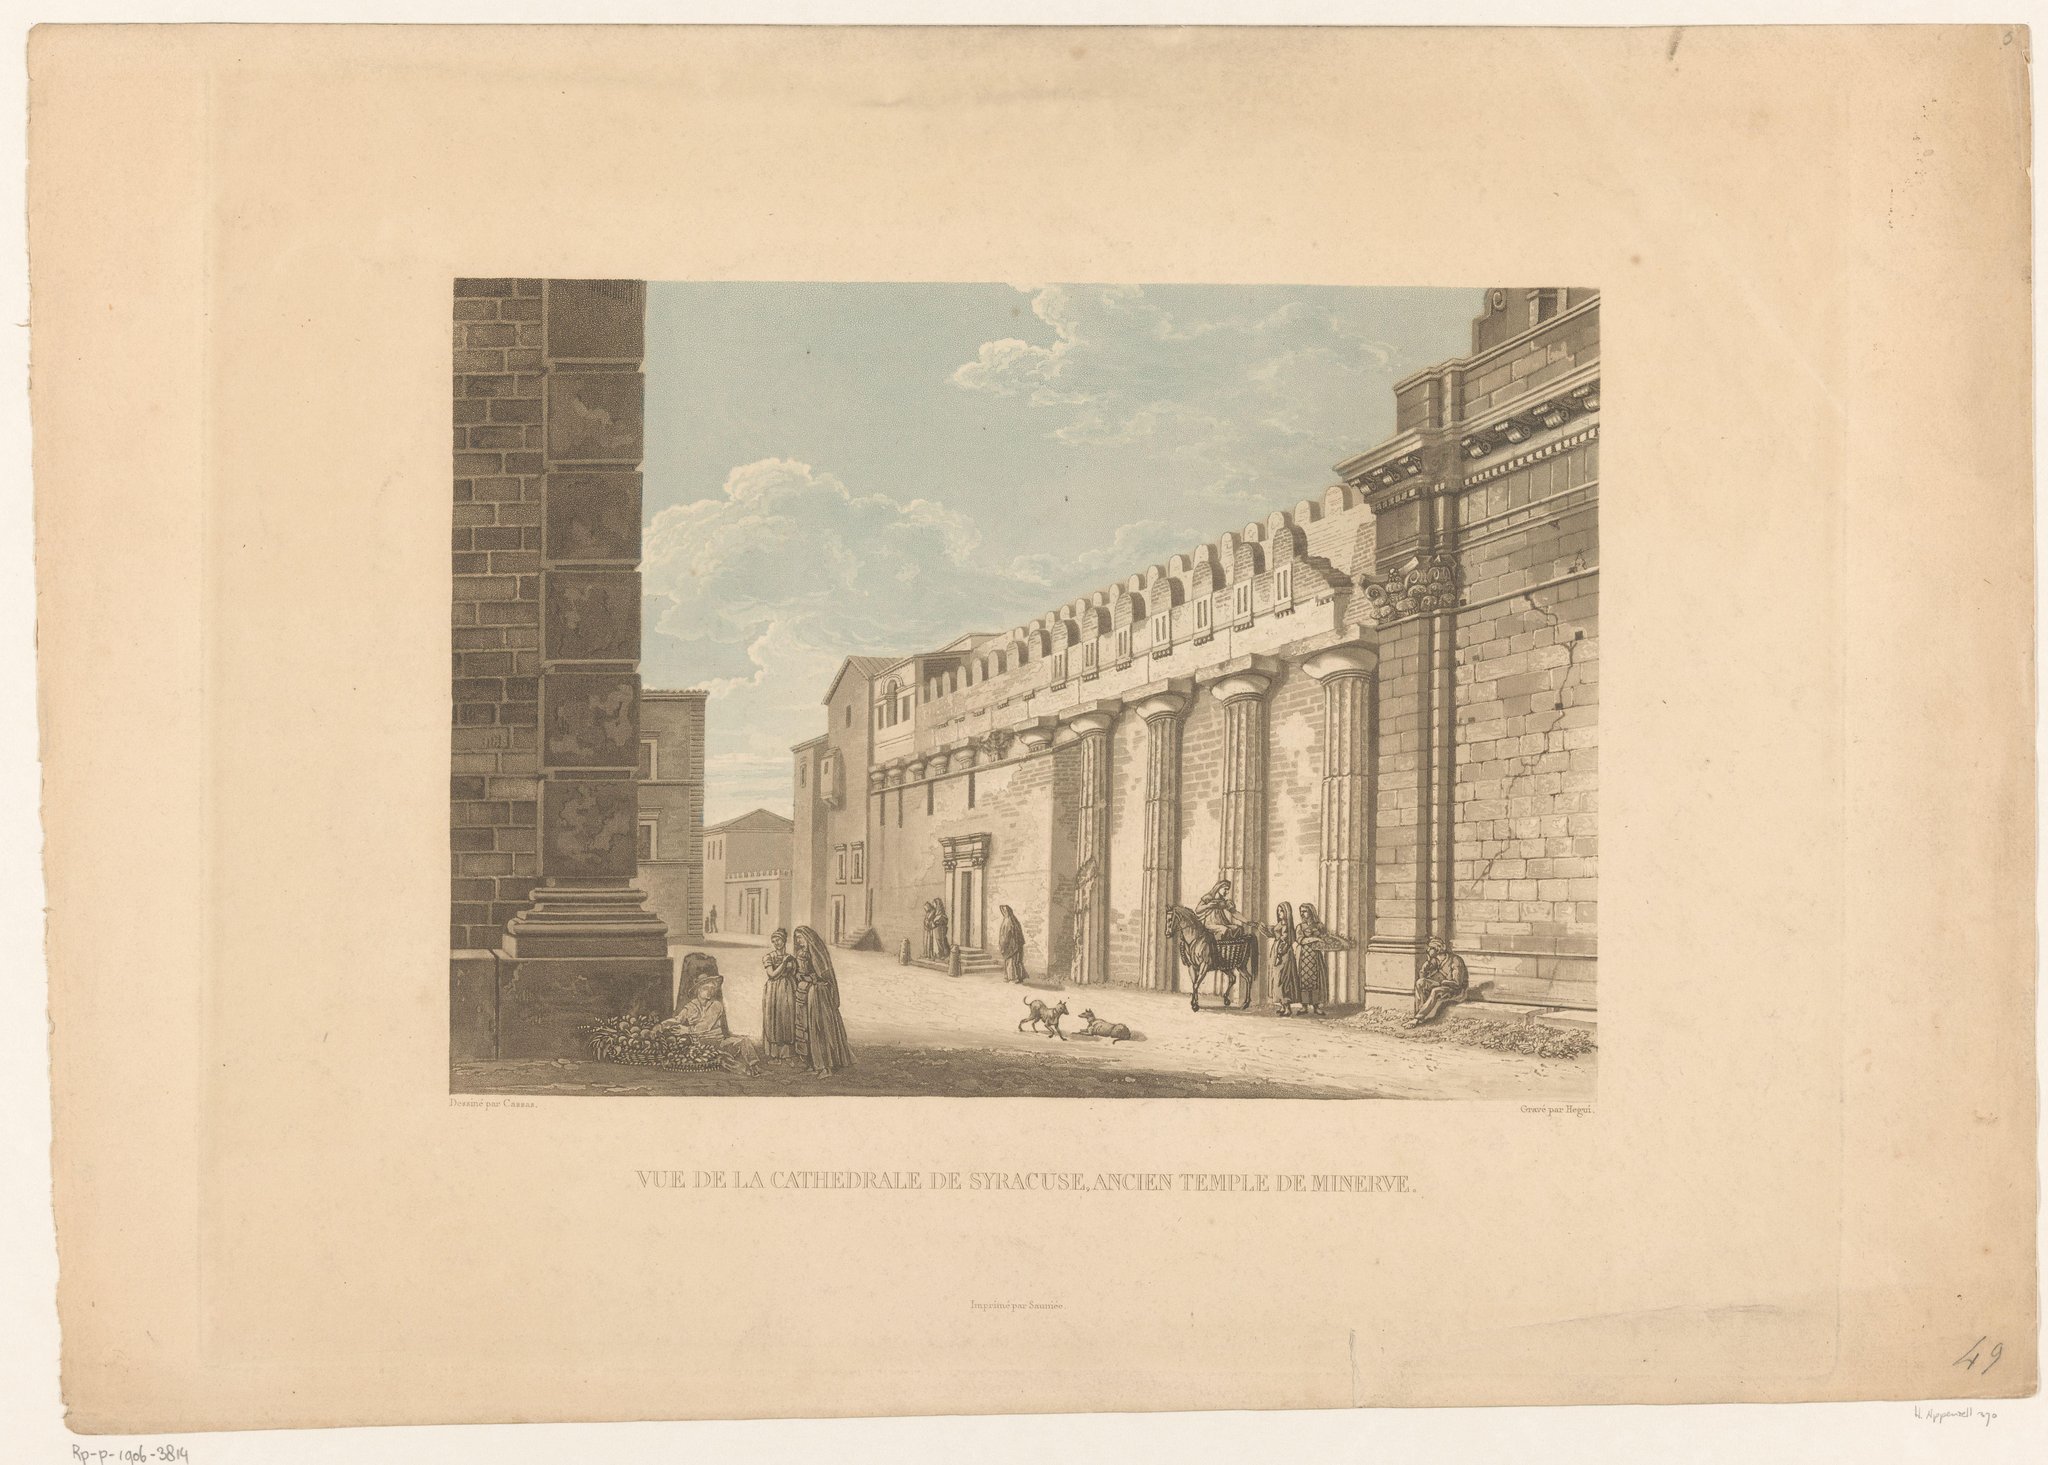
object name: print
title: Vue de la Cathedrale de Syracuse, ancien temple de Minerve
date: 1812-1850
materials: paper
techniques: aquatint, lithography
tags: city-view in general; 'veduta', (story of) minerva (pallas, athena), church (exterior)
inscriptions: collector's mark: Lugt 2228